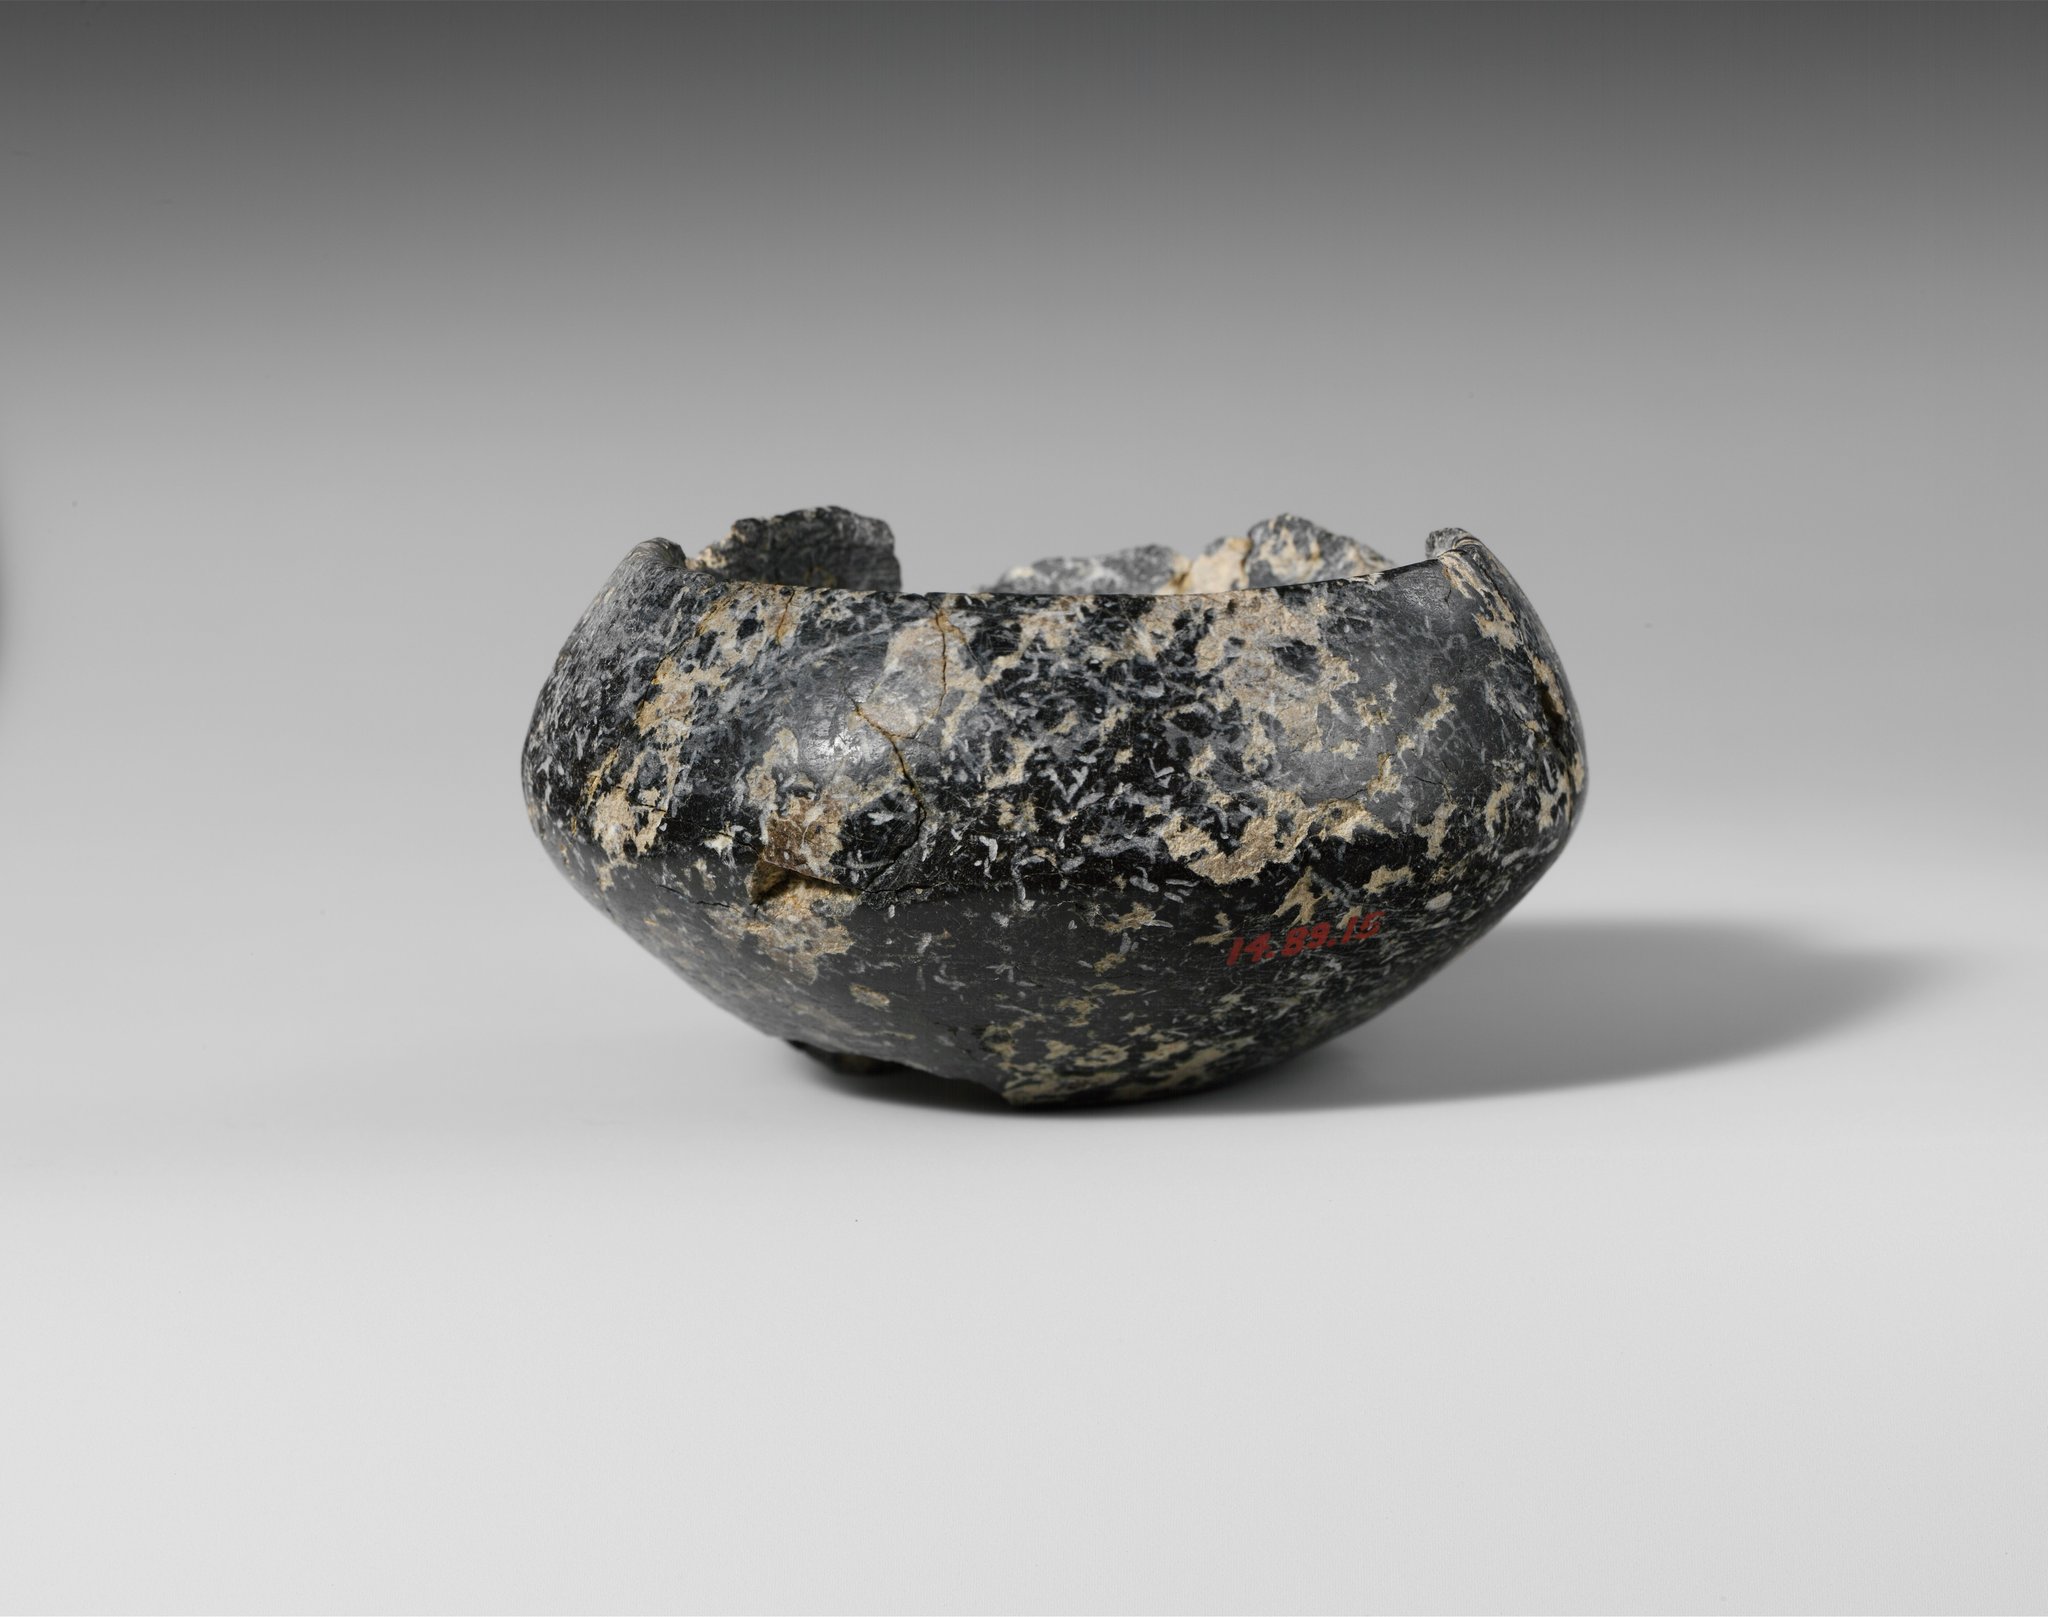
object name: bowl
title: Steatite bowl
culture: minoan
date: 2200-1900 BCE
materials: stone